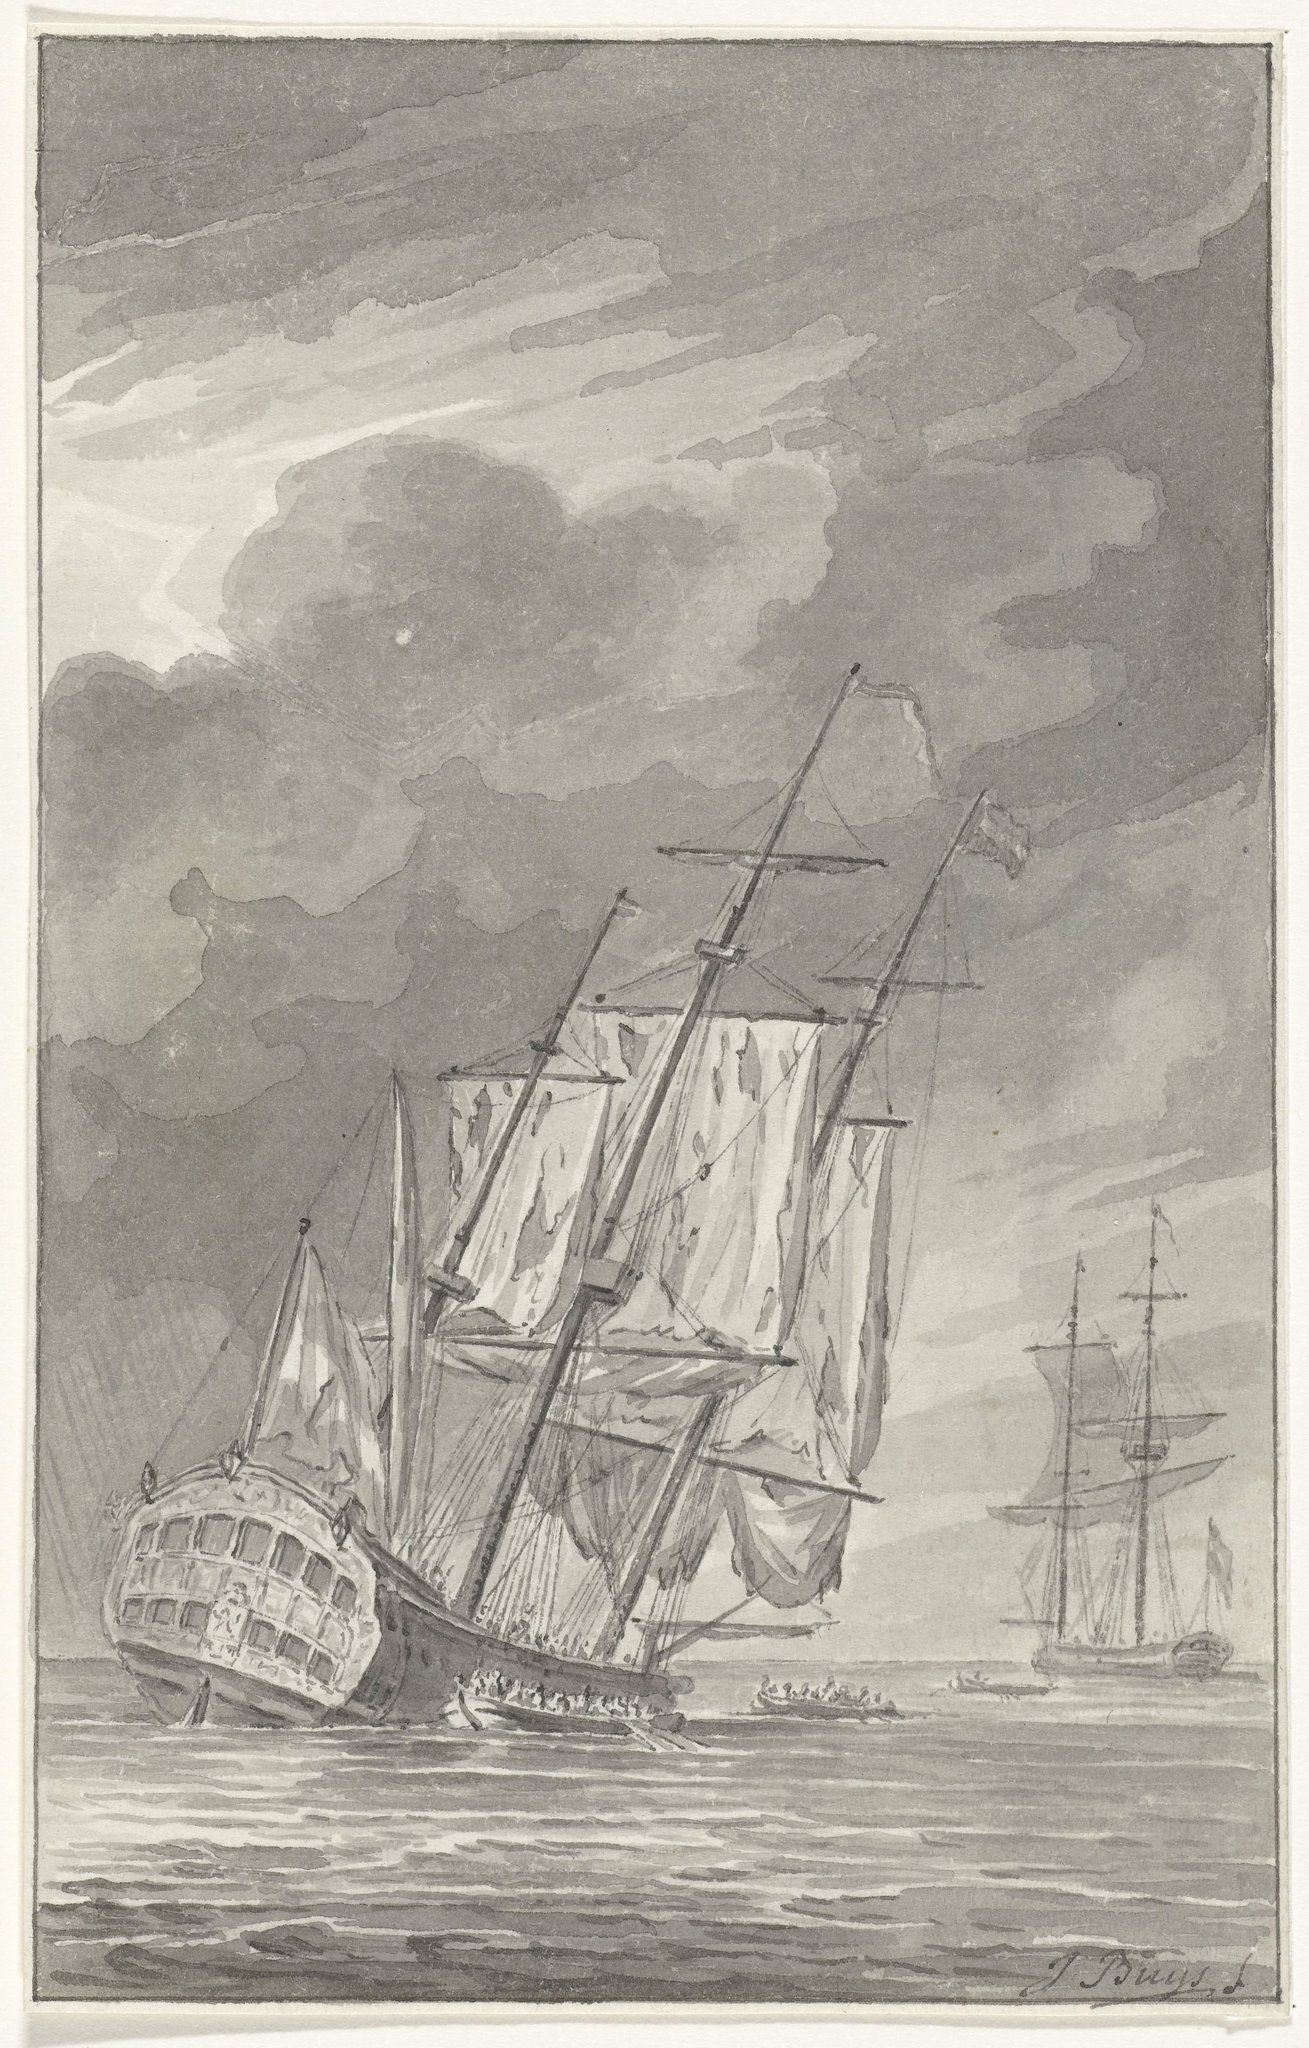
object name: design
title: Het zinkende schip Holland, 1781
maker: jacobus buys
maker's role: draughtsman, print maker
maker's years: 1724-1801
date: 1781-1788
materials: ink, paper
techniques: brush, pen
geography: northern netherlands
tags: sailing-ship, sailing-boat, battle (+ naval force), shipwreck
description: Ontwerptekening voor illustratie in: P.A. Loosjes. Vaderlandsche historie, vervattende de geschiedenissen, der Vereenigde Nederlanden [...]. Ten onmiddelyken vervolge van Wagenaar's Vaderlandsche historie. Dl. 3. Amsterdam: J. Allart, 1788.